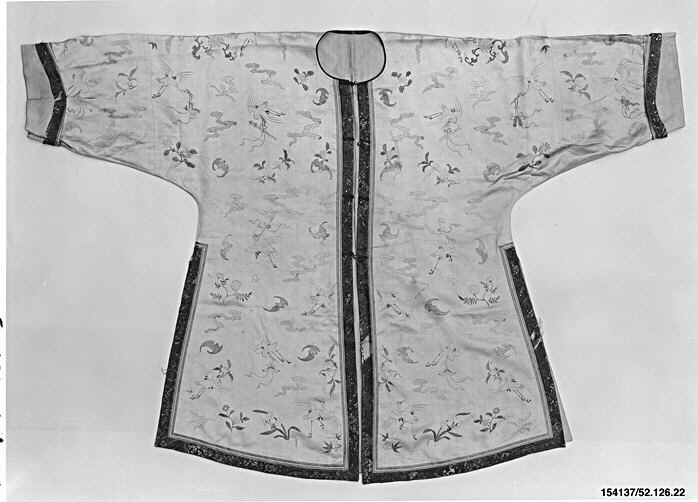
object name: woman's birthday jacket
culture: chinese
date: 1767-1833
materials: textile